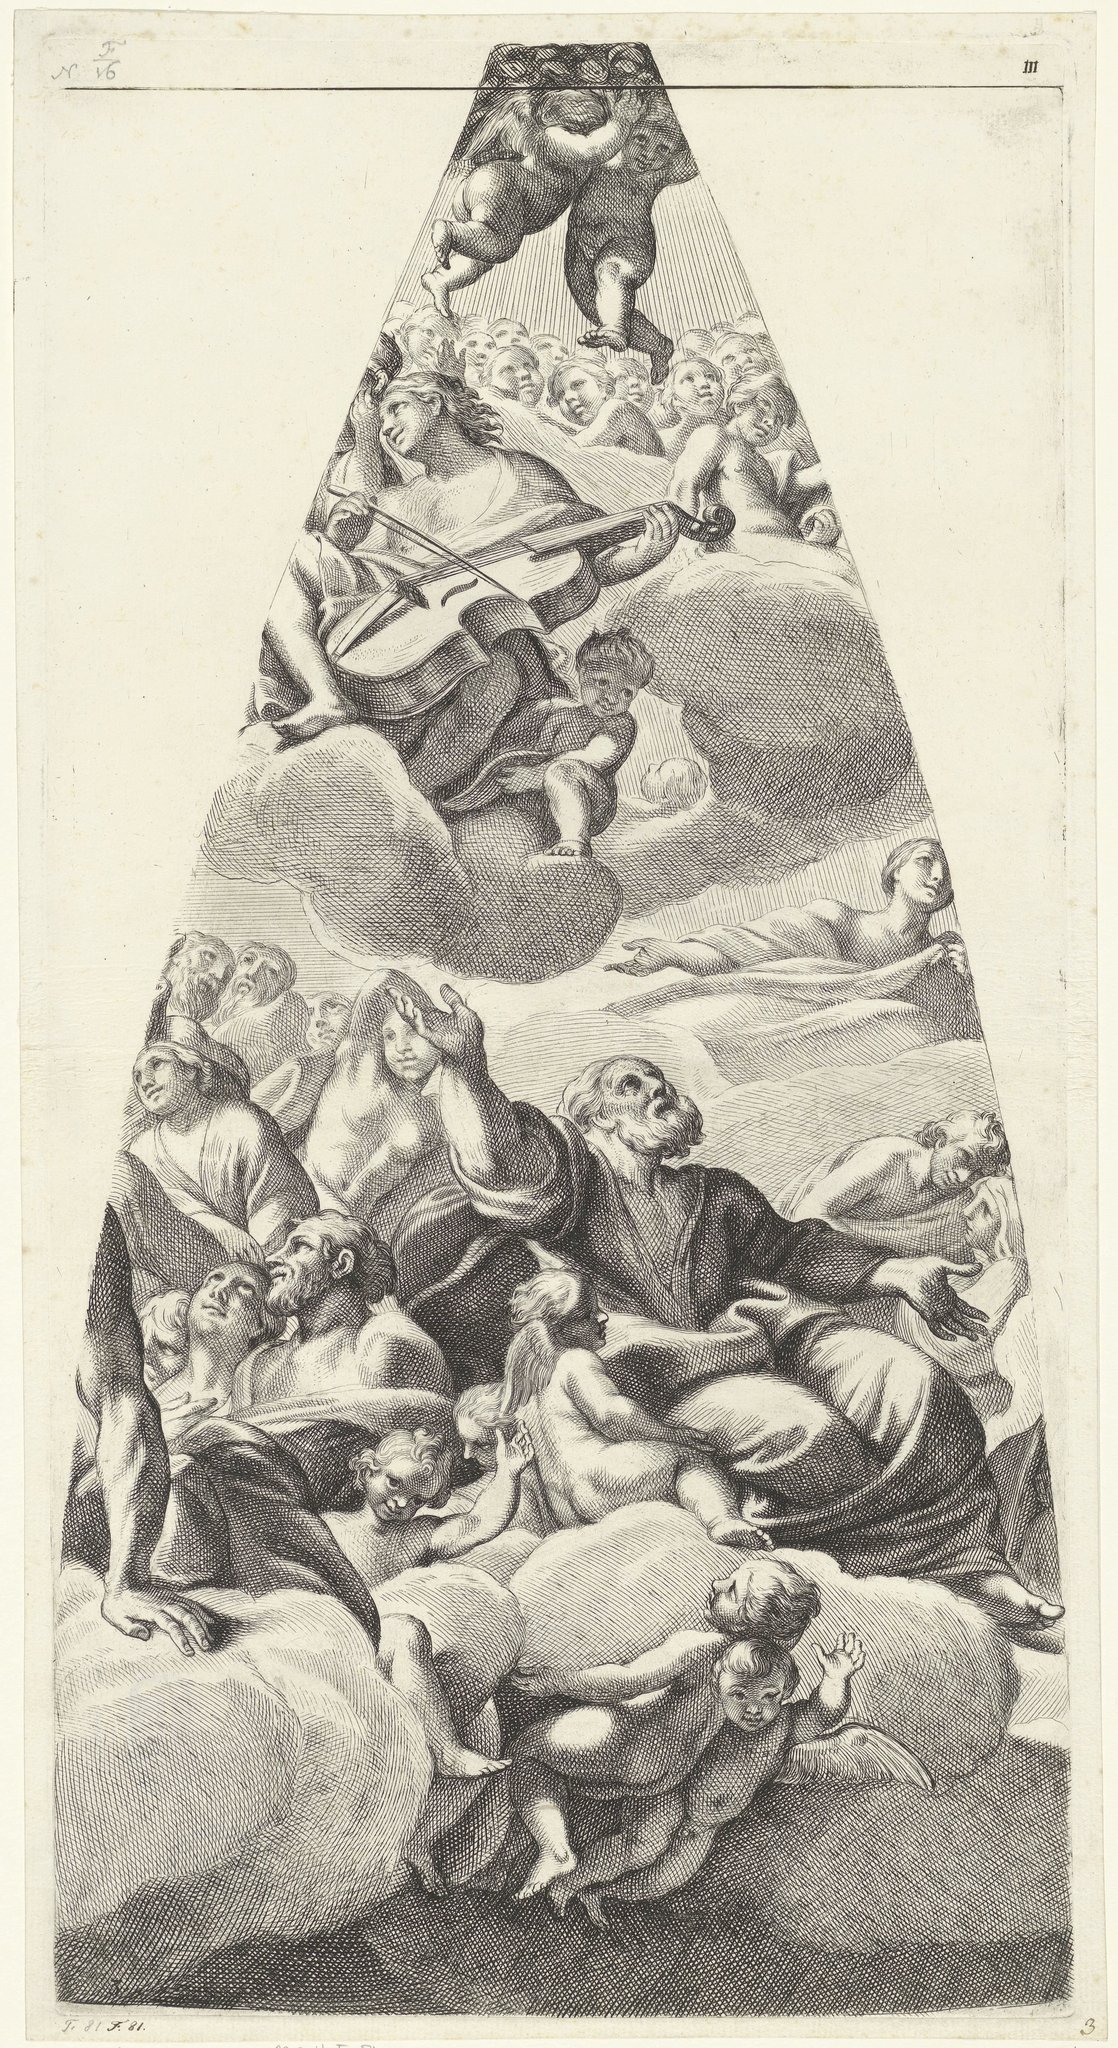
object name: print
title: De heilige Jozef en andere heilige met cellospelende engel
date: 1680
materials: paper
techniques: engraving, etching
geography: rome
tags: angels singing, making music, saints, joseph (not in biblical context), angels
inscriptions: collector's mark: ‘Hinloopen’, collector's mark: Lugt 10, number: ‘3’, collector's mark: Lugt 11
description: Prent uit een reeks van 8 prenten naar de fresco's door Giovanni Lanfranco in de koepel van de San Andrea della Valle te Rome.